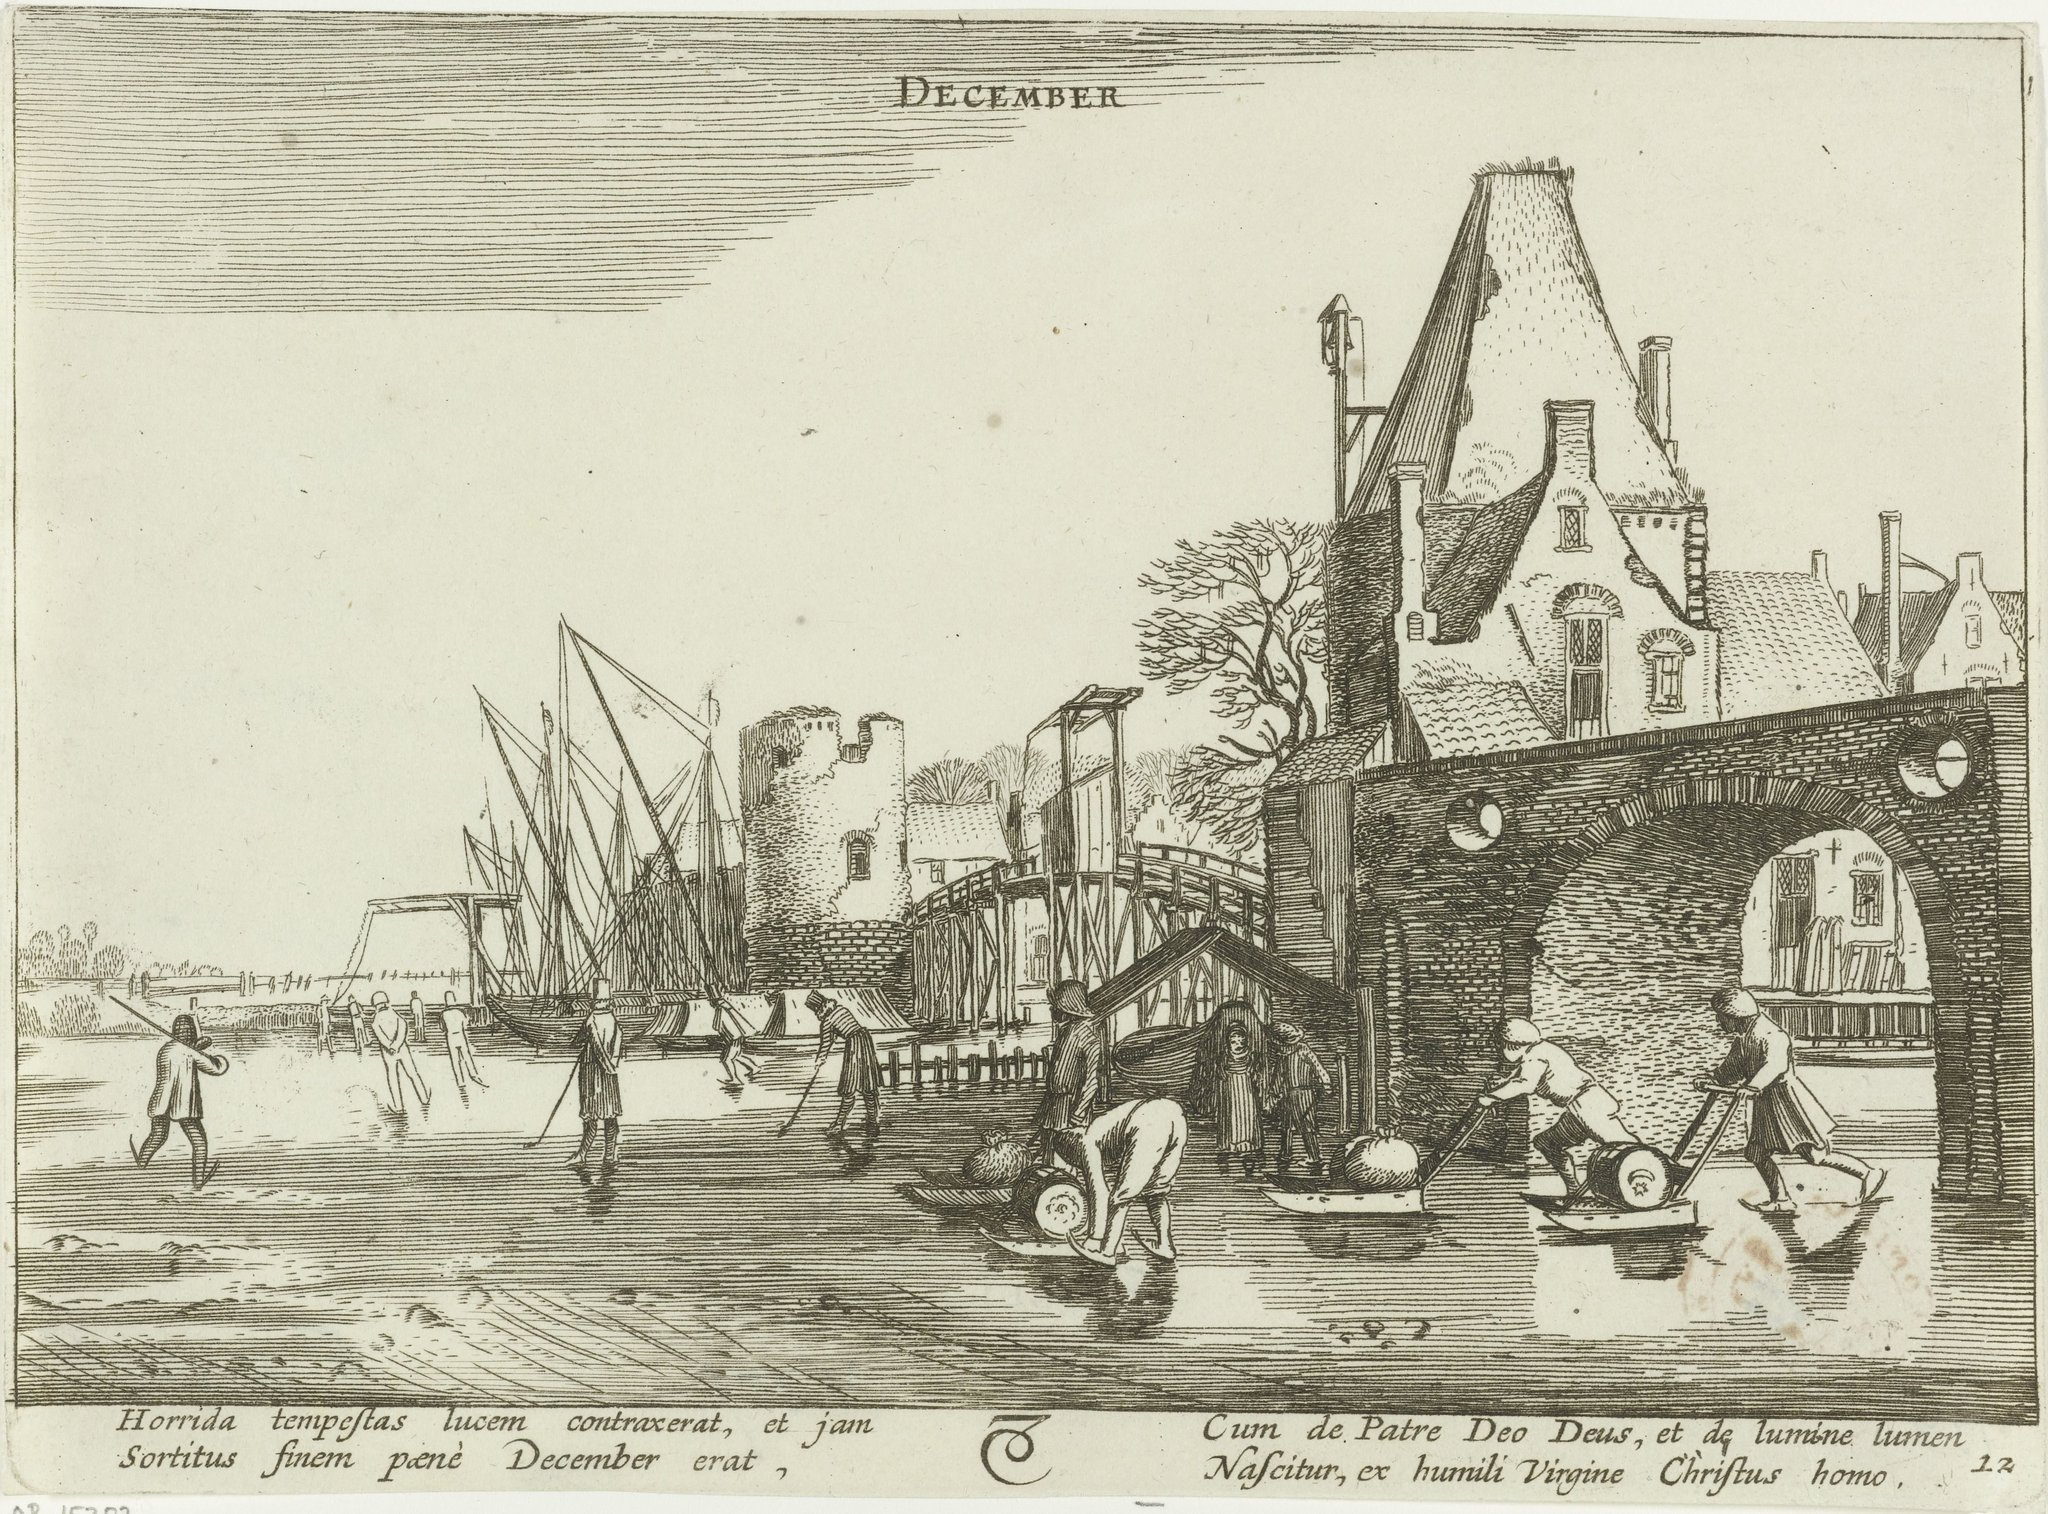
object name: print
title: Duodecim anni mensium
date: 1608-1618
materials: paper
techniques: etching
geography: northern netherlands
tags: landscape symbolizing december, sleigh, sledge (non-sport), skates (winter sports), 'kolf' on the ice, capricorn (zodiacal sign of december), outskirts of village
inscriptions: collector's mark: Lugt 698, collector's mark: Lugt 240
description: Een dorpsgezicht met kolfspeleres en figuren met vracht op sledes op het ijs, voorstellende de maand december. Rechts de rand van een dorp met een stenen brug. Onderaan het astrologische symbool van het sterrenbeeld boogschutter. Prent uit een serie van twaalf.